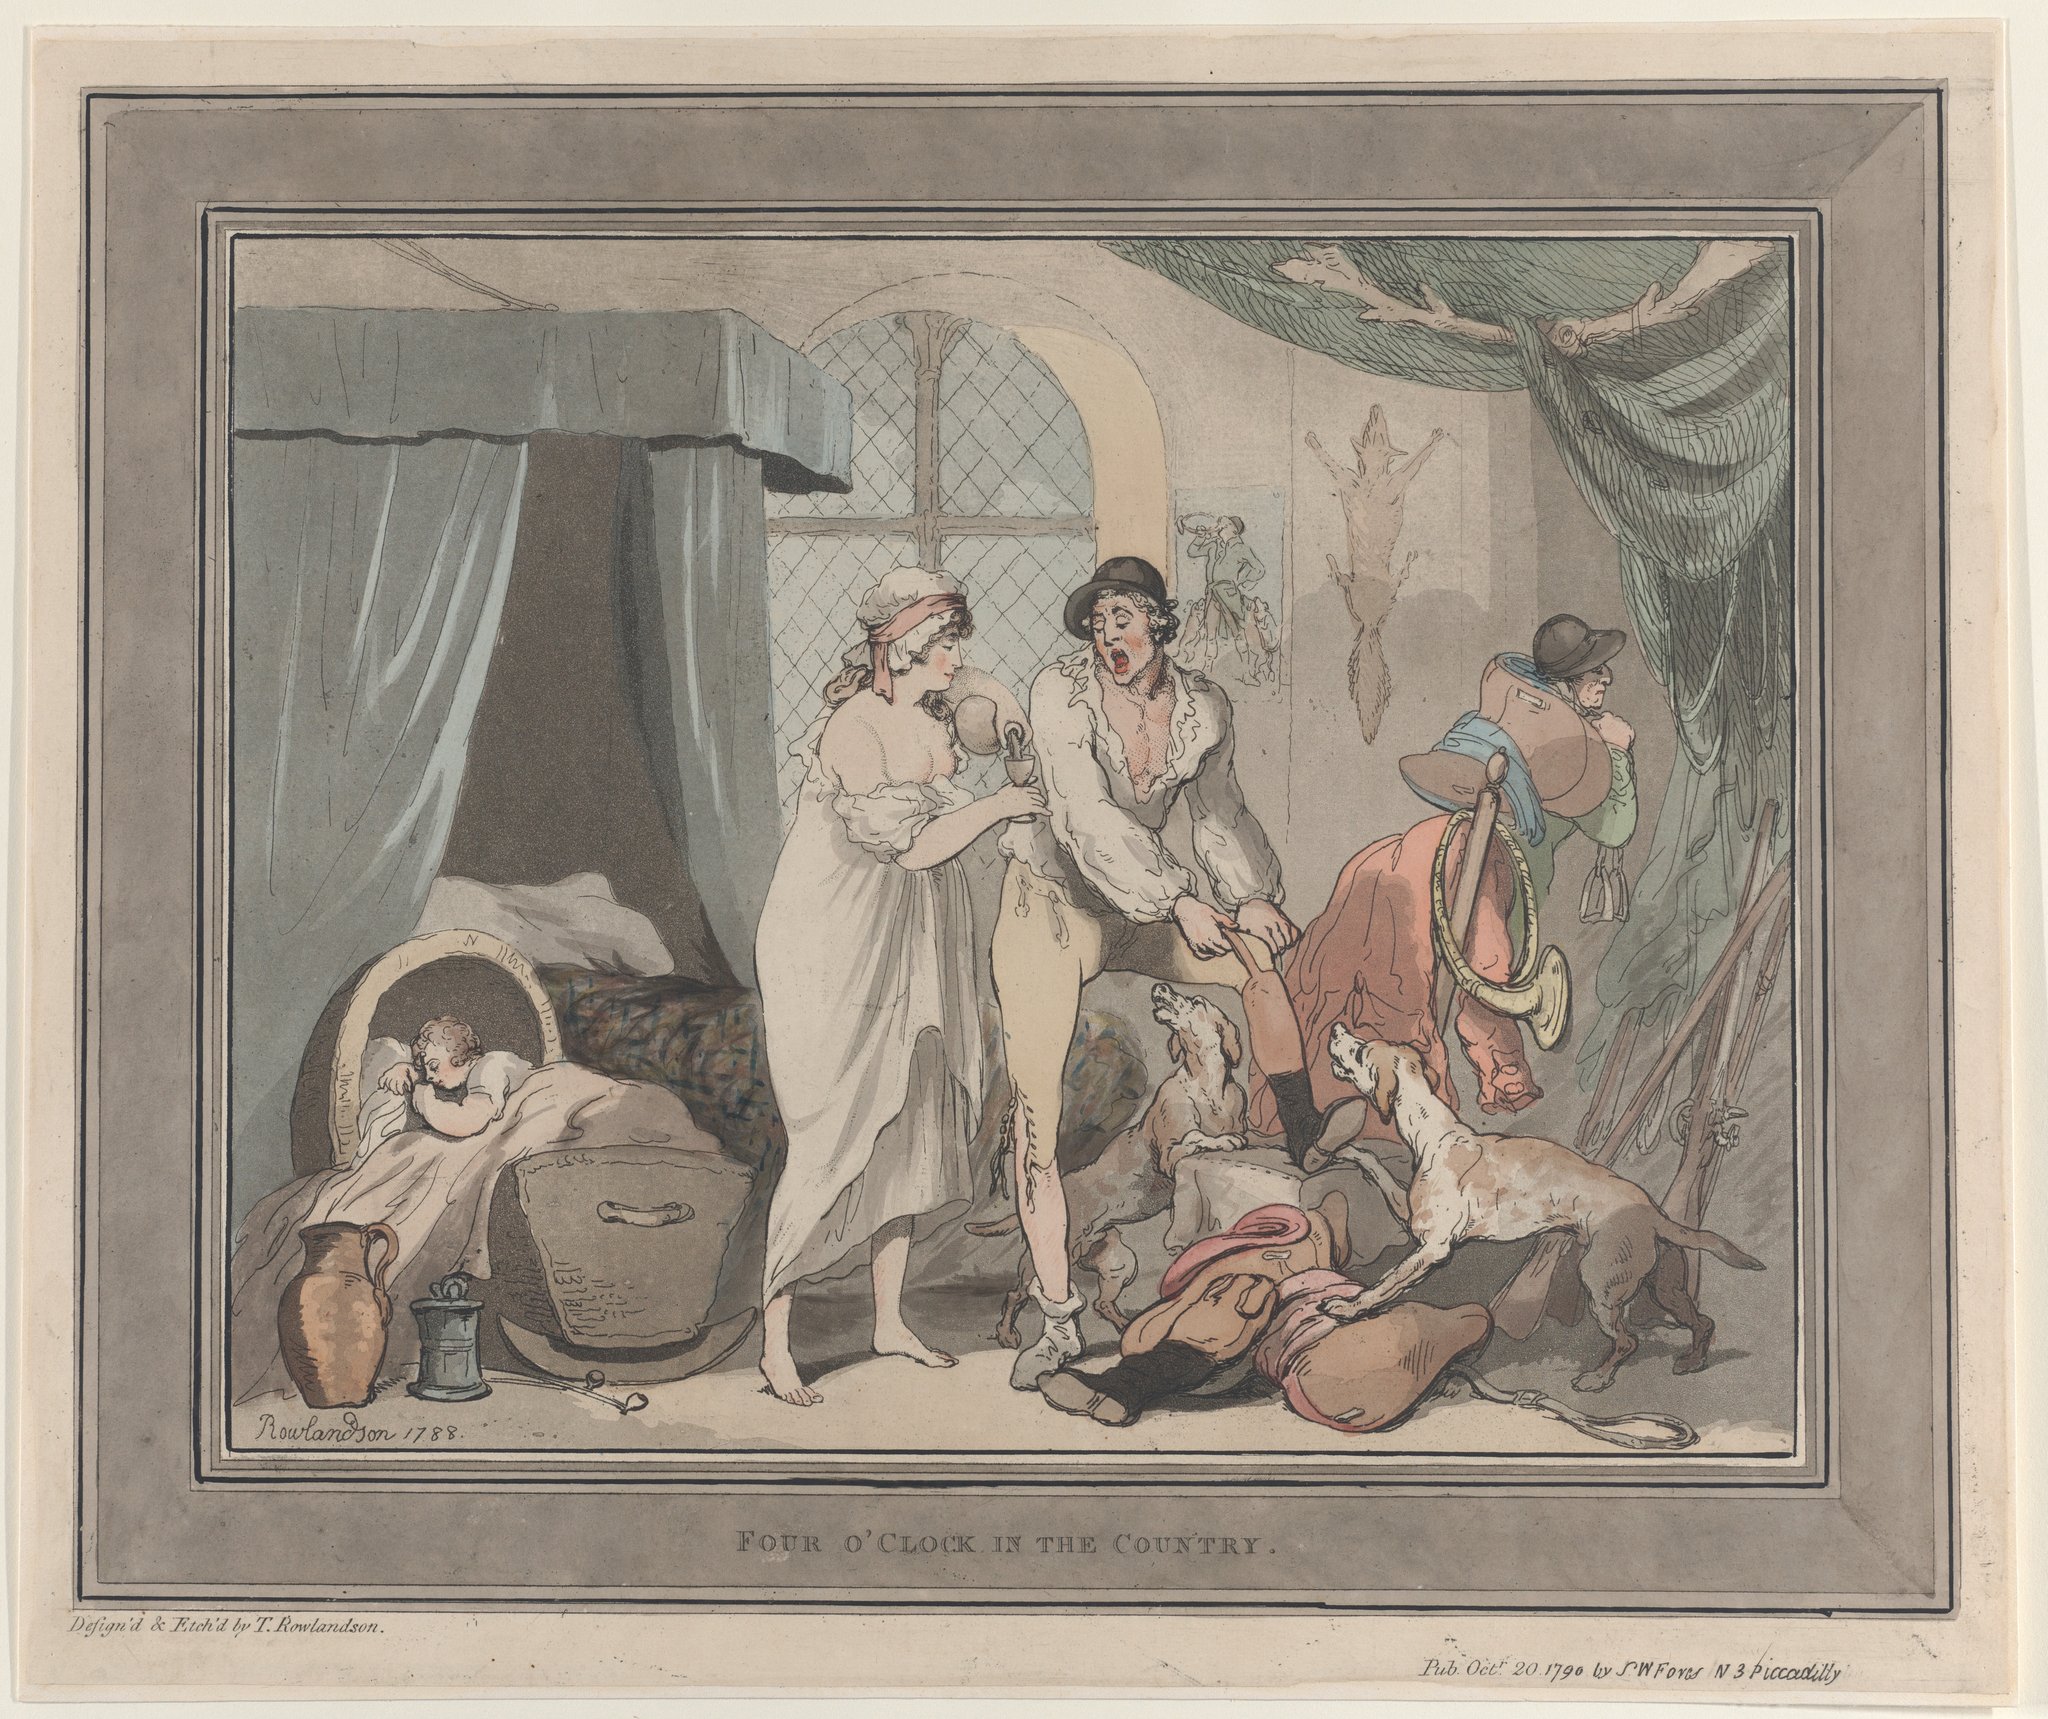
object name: print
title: Four O'Clock in the Country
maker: thomas rowlandson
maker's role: artist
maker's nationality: british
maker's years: 1757-1827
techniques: etching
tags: satire,children,men,women,dogs,beds